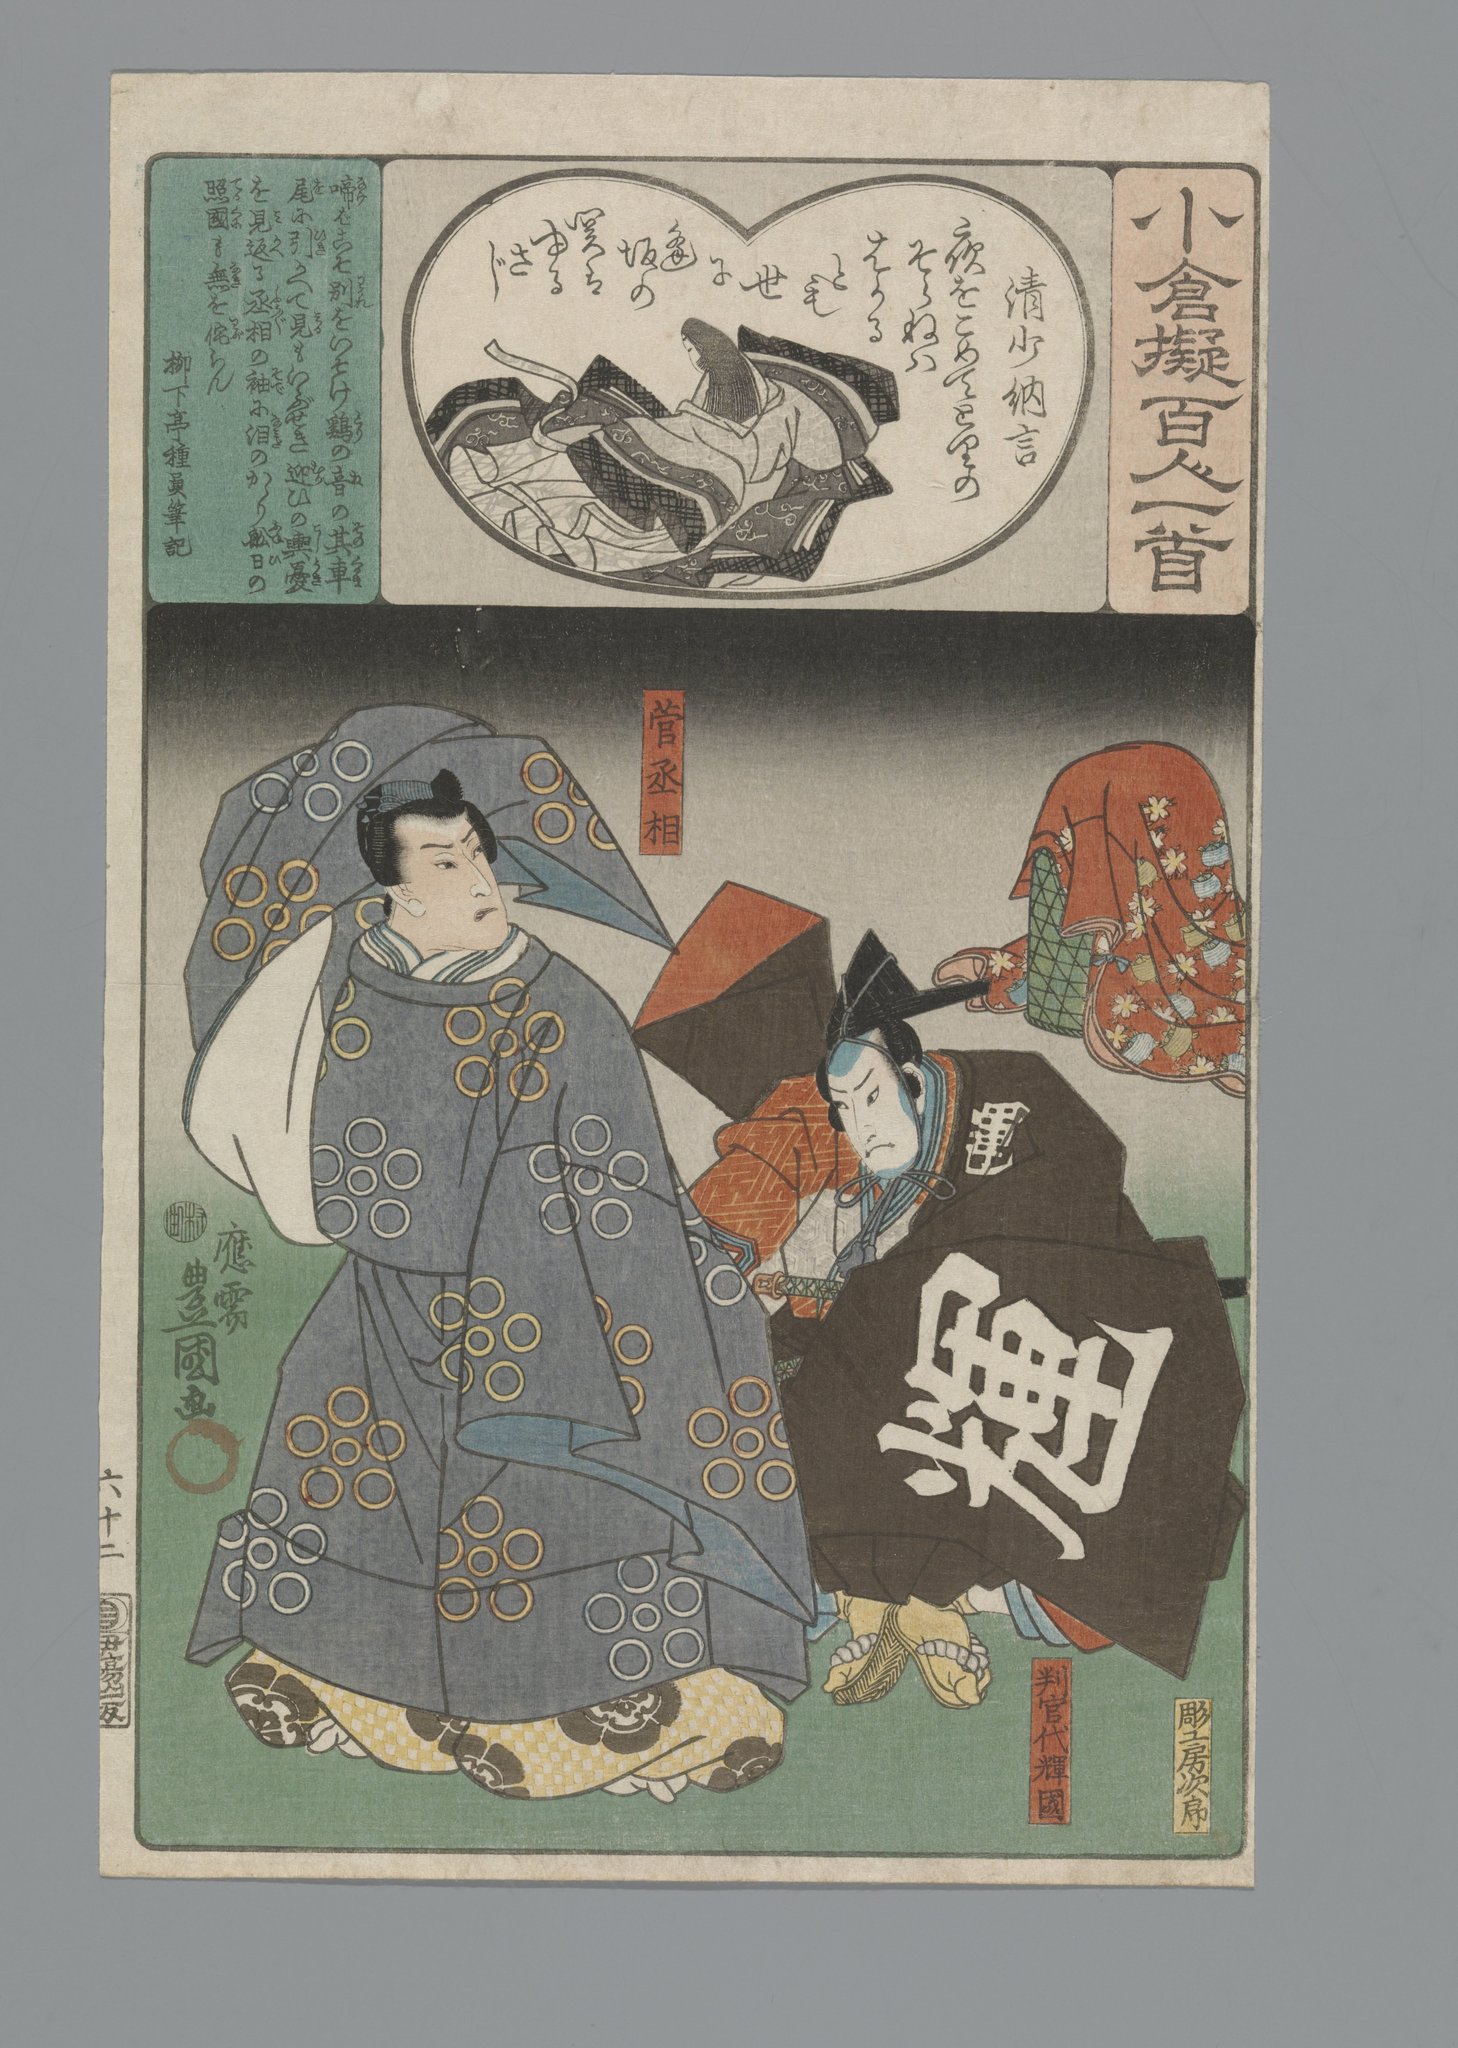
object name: print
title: Ogura Imitation of the One Hundred Poems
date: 1846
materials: paper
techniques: woodcut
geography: japan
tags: container made of plant material other than wood: basket, hiding, hiding oneself, guard duty, keeping sentry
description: De verbannen Sugawara no Michizane, met achter zich zijn bewaker Terukuni, kijkt om naar de mand waarover een rode kimono ligt. In de mand zit zijn dochter verstopt, die op deze manier nog een laatste keer haar vader kan zien. Scene uit een kabukitoneelstuk. Gedicht door Sei Shônagon.